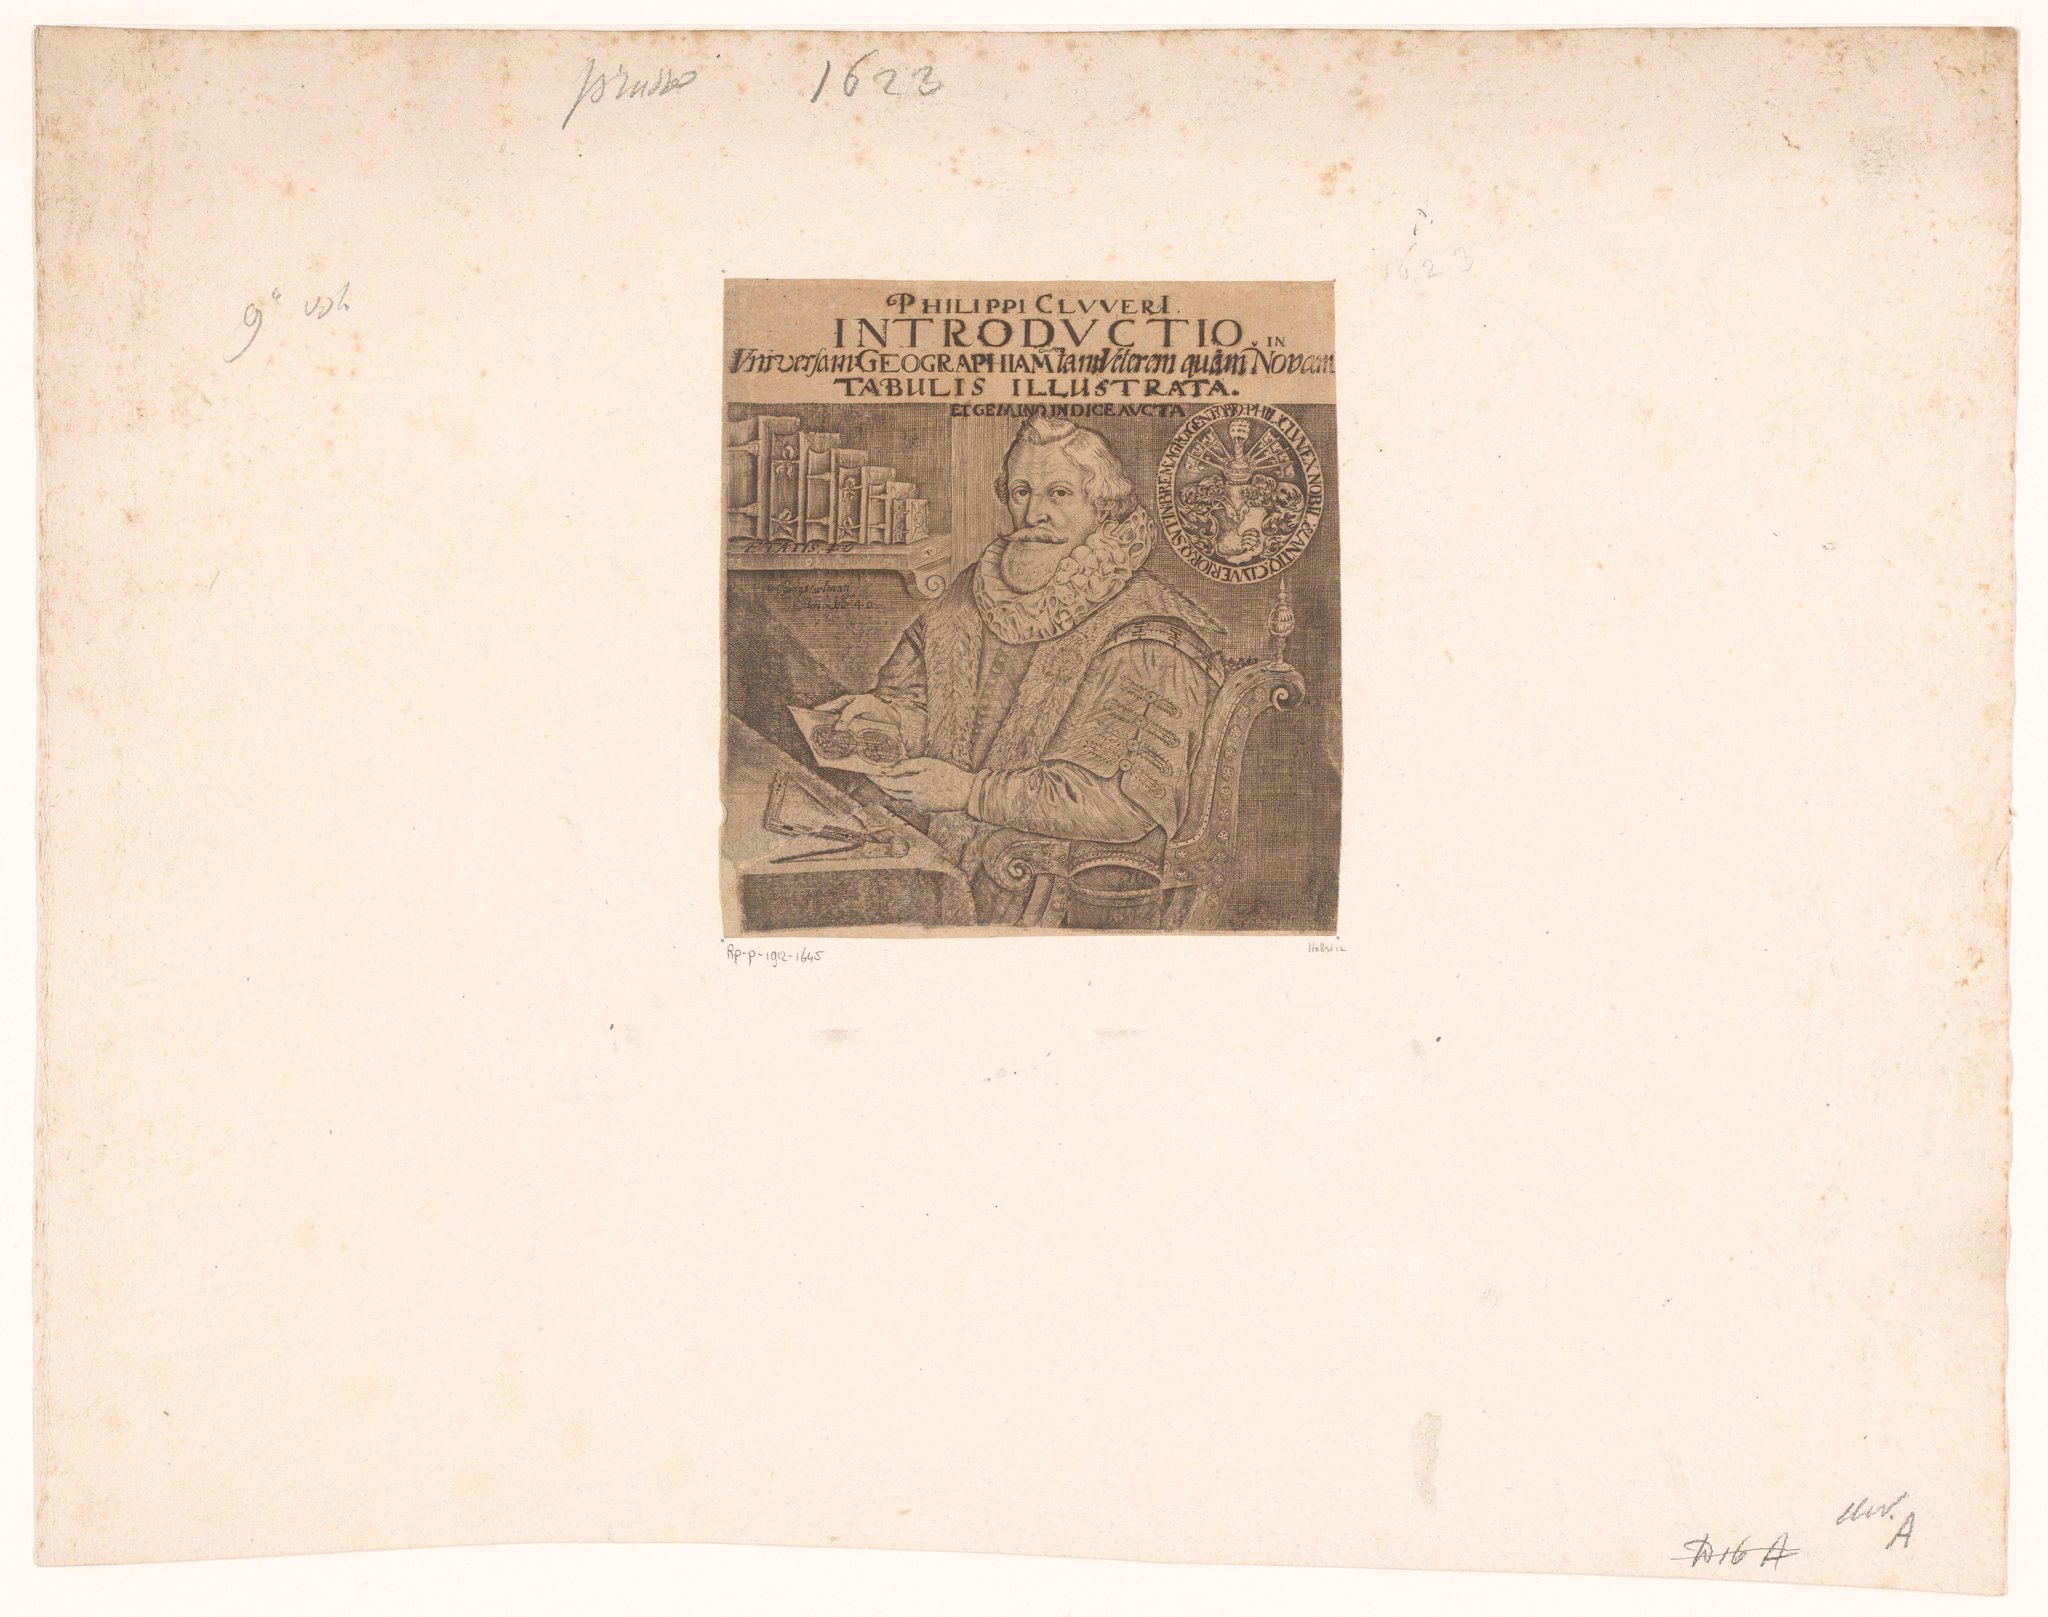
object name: book illustration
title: Portret van Philipp Clüver op 40-jarige leeftijd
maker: wolfgang hartmann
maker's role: print maker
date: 1640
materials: paper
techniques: engraving, etching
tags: leiden, bookshelves, historical persons, map making, armorial bearing, heraldry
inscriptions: collector's mark: Lugt 2228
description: Prent uit: Cluver, Philipp. Introductionis in universam geographiam, tam veterem quam novum. S.l.s.n., [1641].